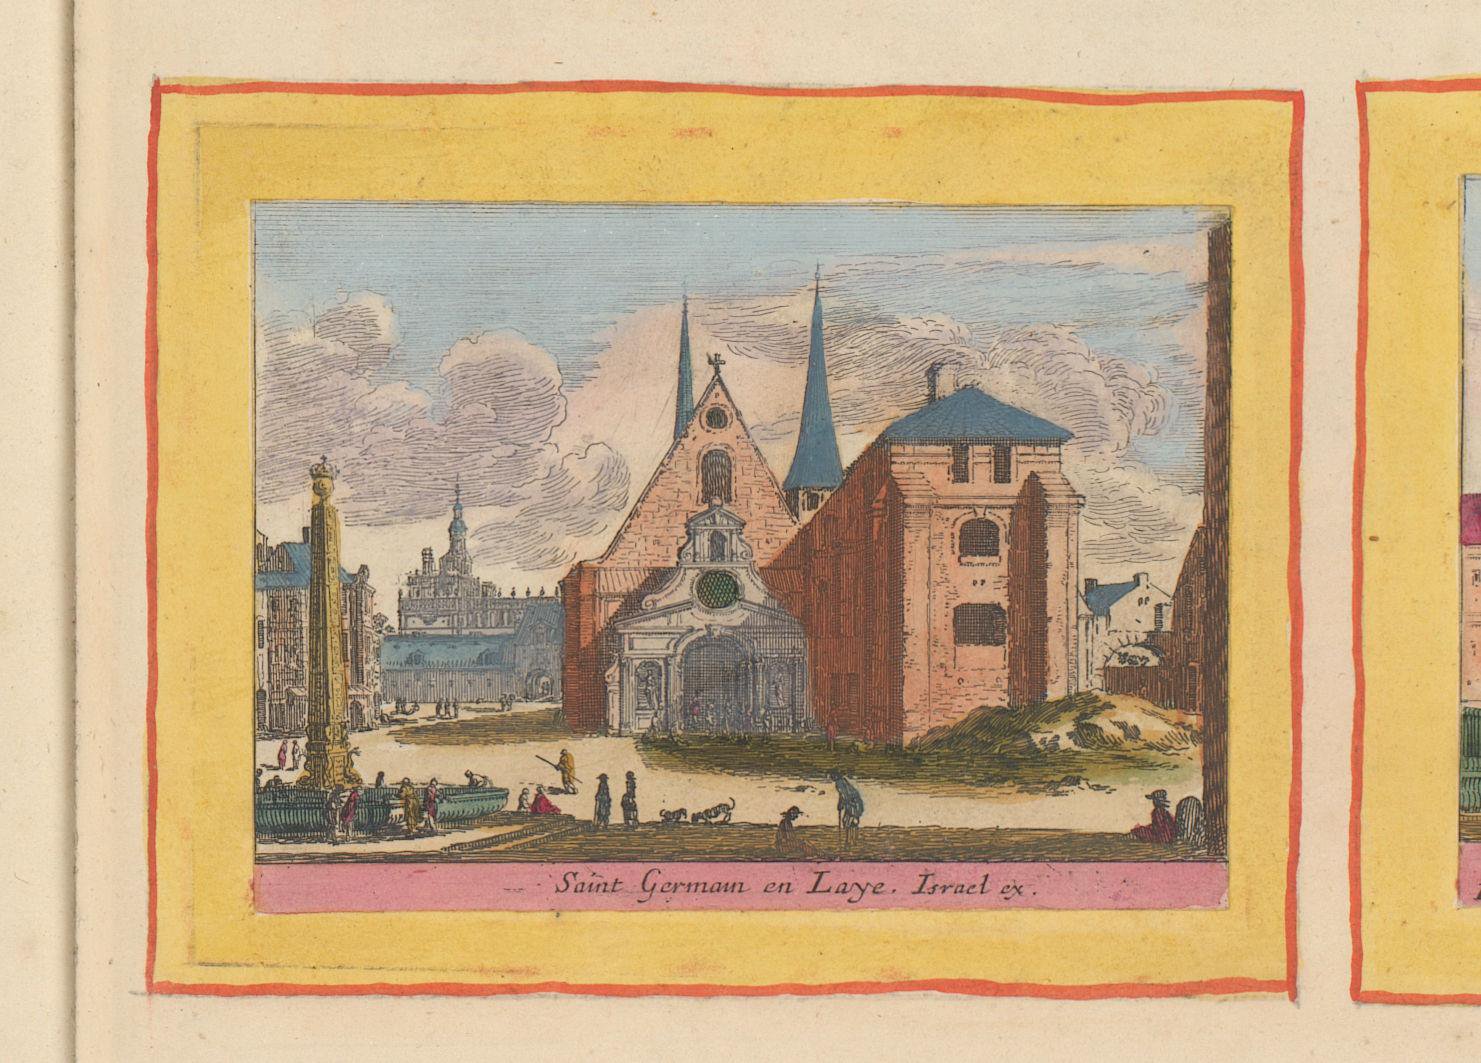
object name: album leaf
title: Gezicht op een plein in Saint-Germain-en-Laye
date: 1631-1661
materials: paper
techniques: etching, hand coloring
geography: paris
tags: ornamental fountain (in village)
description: Gezicht op een plein met fontein en kerk in Saint-Germain-en-Laye. Prent maakt deel uit van een album.